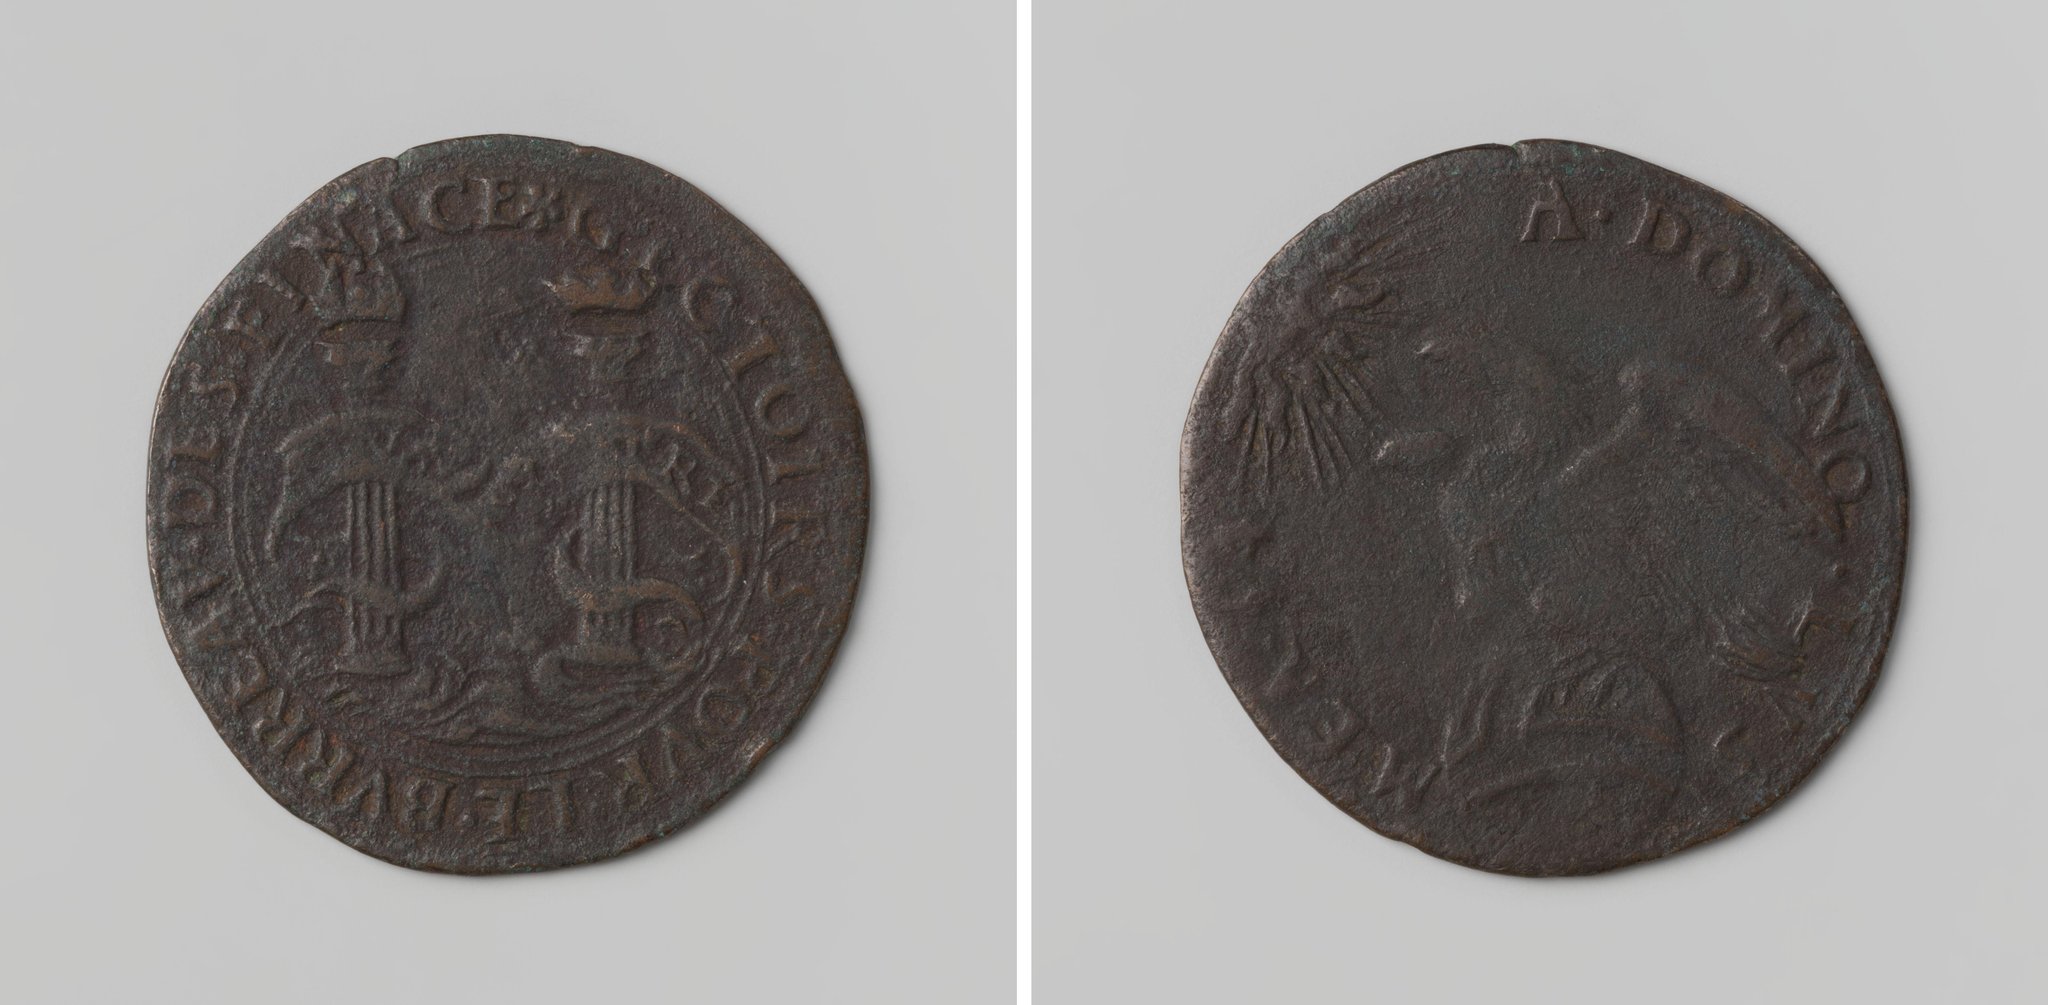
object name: jeton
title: Karel V, Duits keizer, rekenpenning van de raad van Financiën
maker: Anonymous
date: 1554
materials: copper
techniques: striking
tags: ghent, charles v (holy roman emperor and king of spain)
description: Koperen penning. Voorzijde: gekroonde zuilen van Herkules, verbonden door wimpel met opschrift binnen omschrift. Keerzijde: adelaar op wereldbol, omhoog kijkend naar stralende zon binnen omschrift